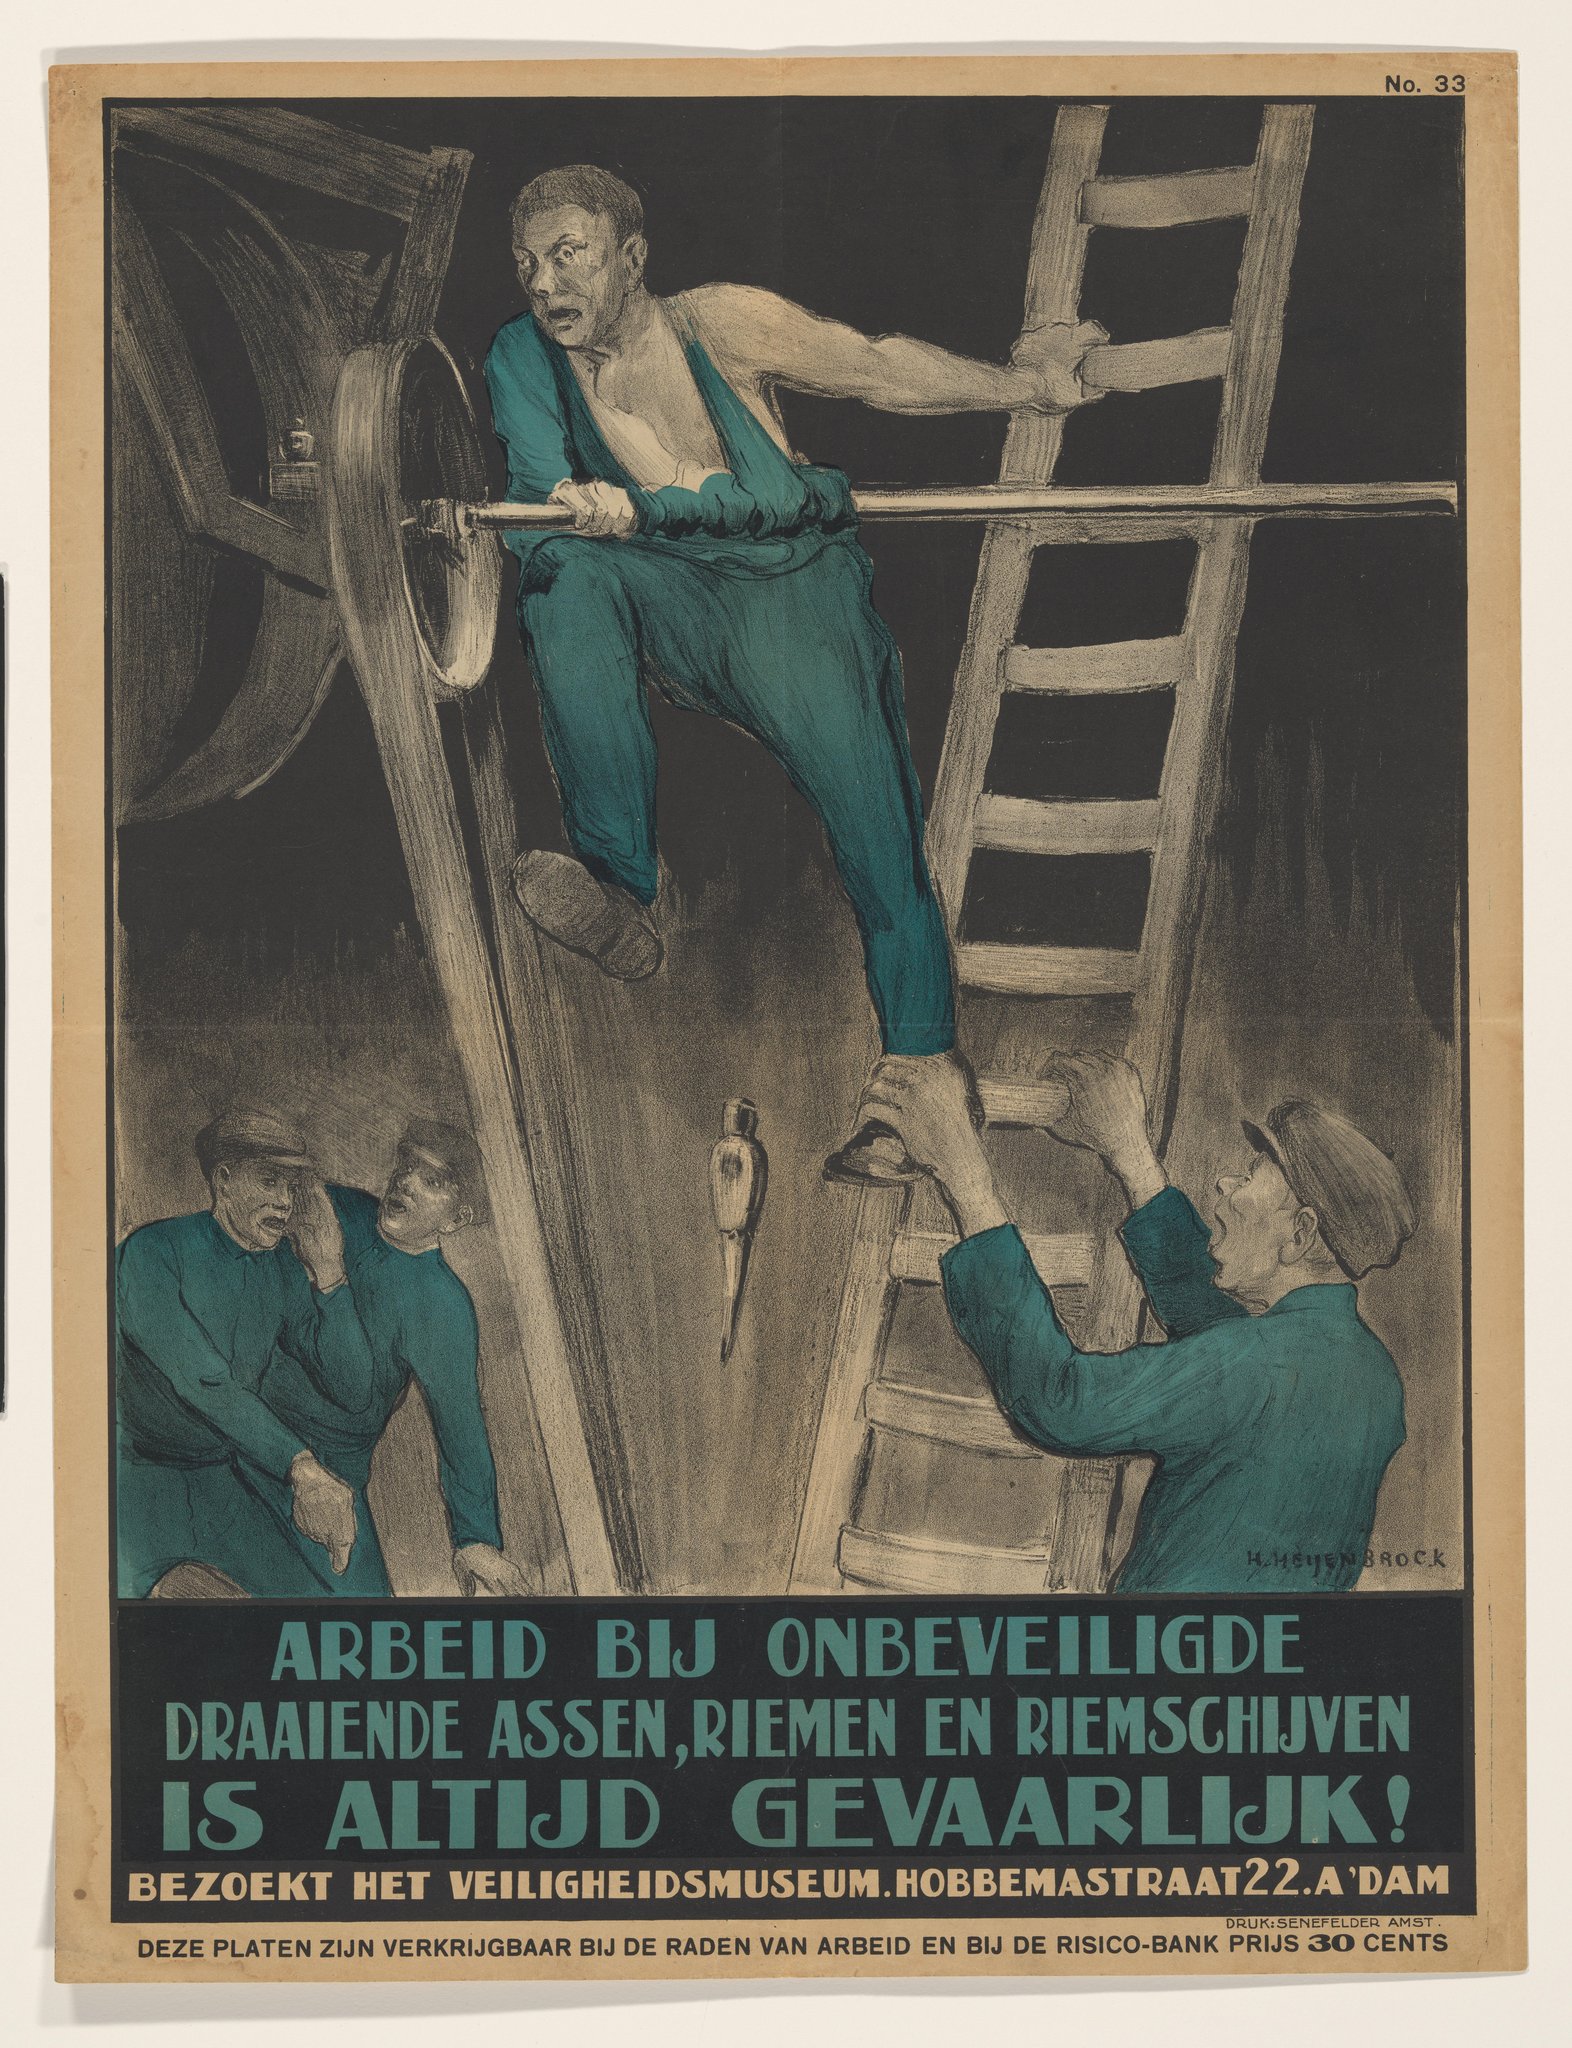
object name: poster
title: Arbeid bij onbeveiligde draaiende assen, rieme en riemschijven is altijd gevaarlijk!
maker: herman heijenbrock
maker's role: draughtsman, painter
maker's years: 1871-1948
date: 1920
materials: paper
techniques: lithograph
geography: netherlands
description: poster uitgegeven door het Veiligheids Instituut/Veiligheids Museum